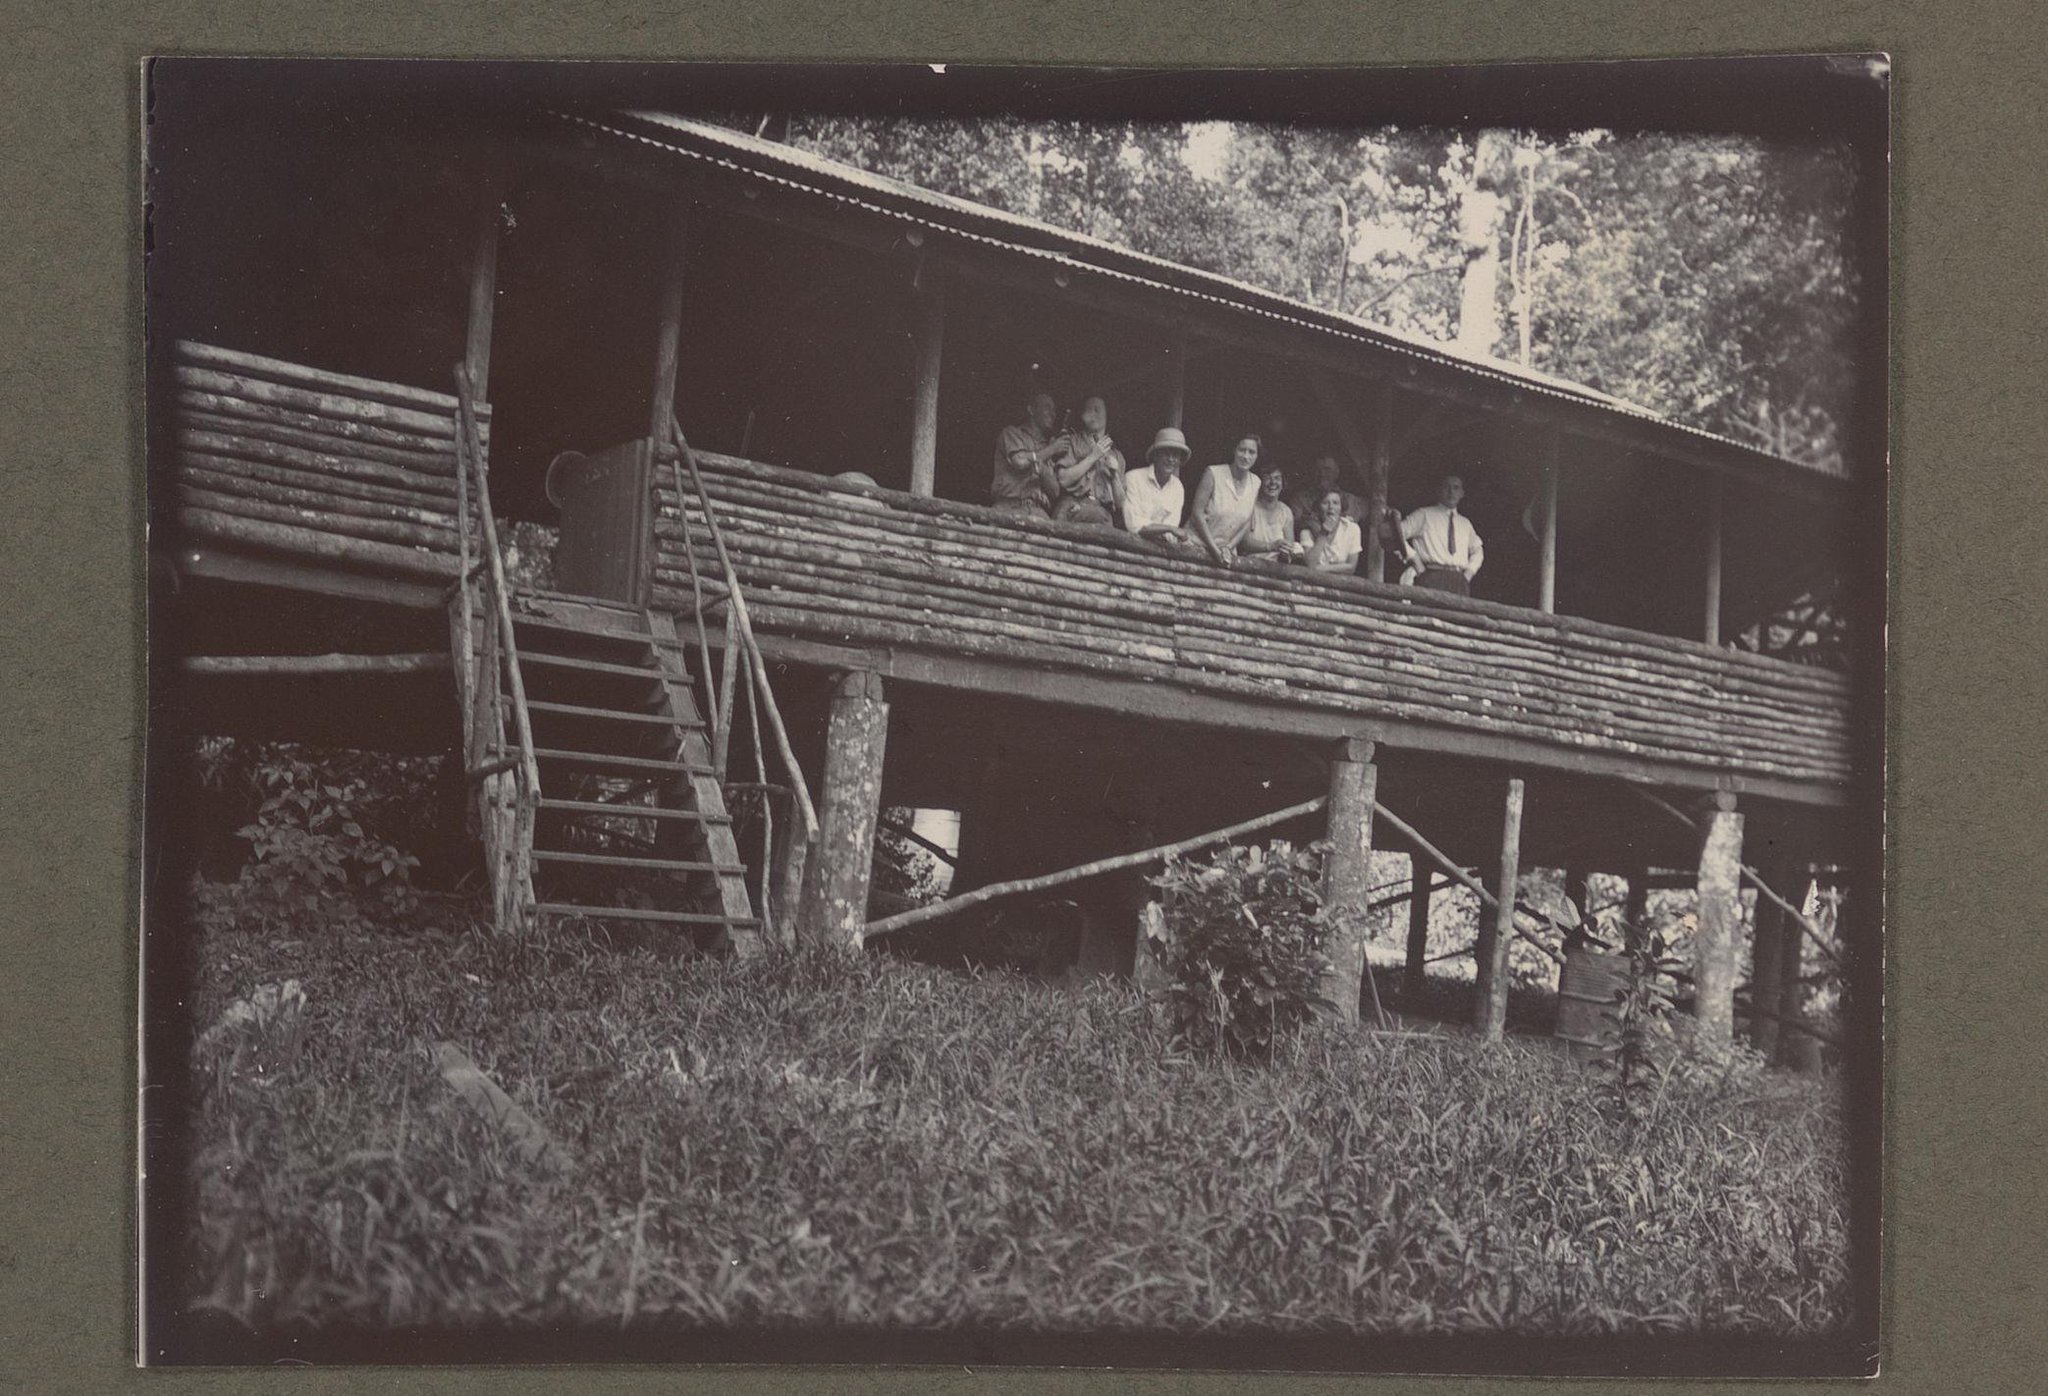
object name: photograph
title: Bezoek aan een dorp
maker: Anonymous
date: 1925-1927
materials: photographic support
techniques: photography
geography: suriname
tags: jetten, familie, moengo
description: Bezoek aan een inlands dorp door een groep Nederlanders waaronder het echtpaar Jetten. Foto op een bladzijde van een los albumblad. Onderdeel van het ensemble met foto's van de familie van ingenieur Jetten in de mijnbouwstad Moengo in Suriname.